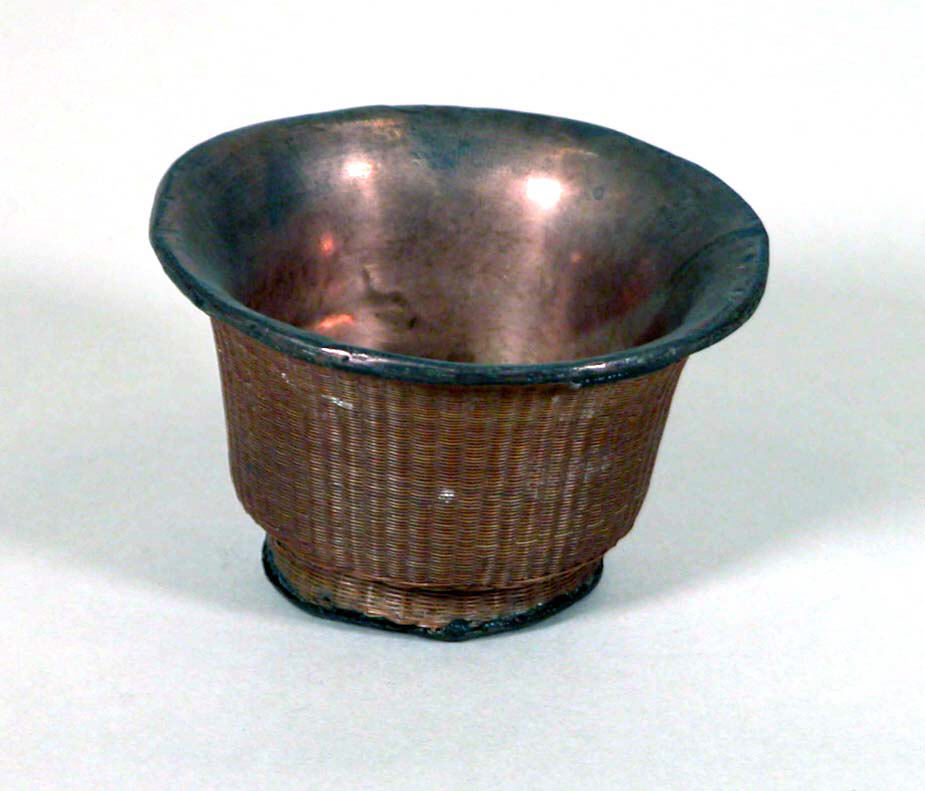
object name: cup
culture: chinese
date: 1701-1800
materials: bamboo, lacquer